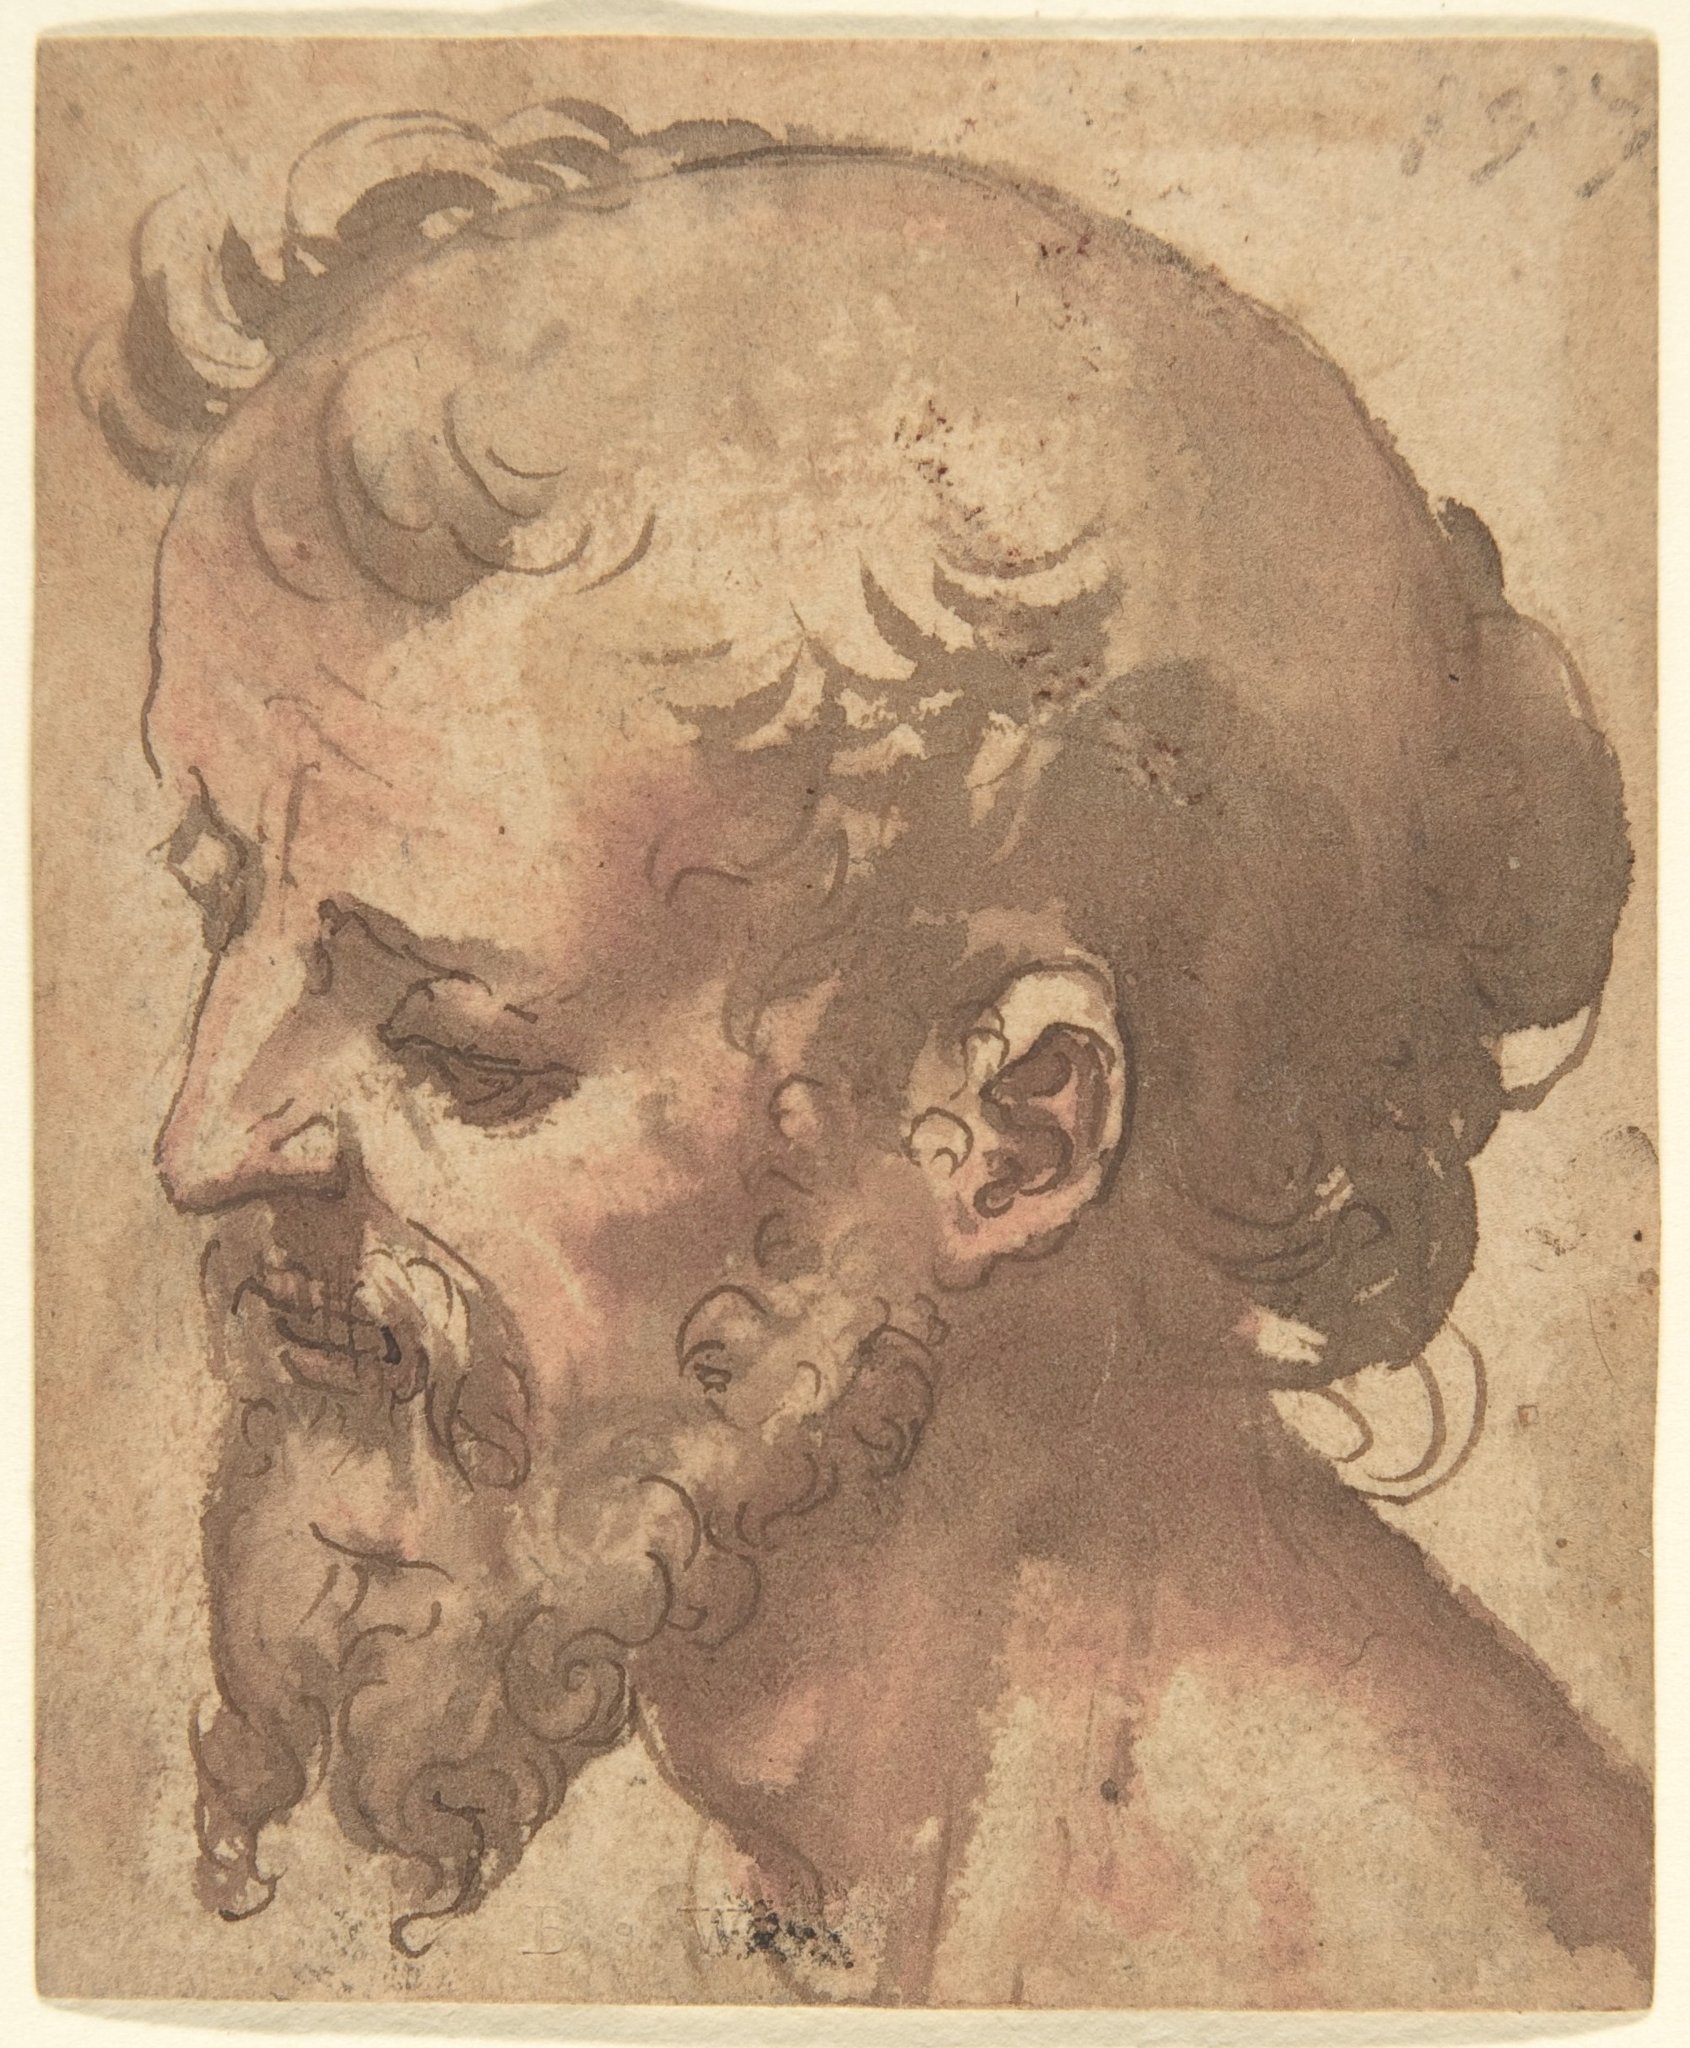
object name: drawing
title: Head of a Bearded Man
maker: anonymous, italian, sienese, 16th century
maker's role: artist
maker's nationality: italian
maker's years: 1500-1600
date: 1500-1550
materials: ink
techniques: brush, pen, wash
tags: heads,men